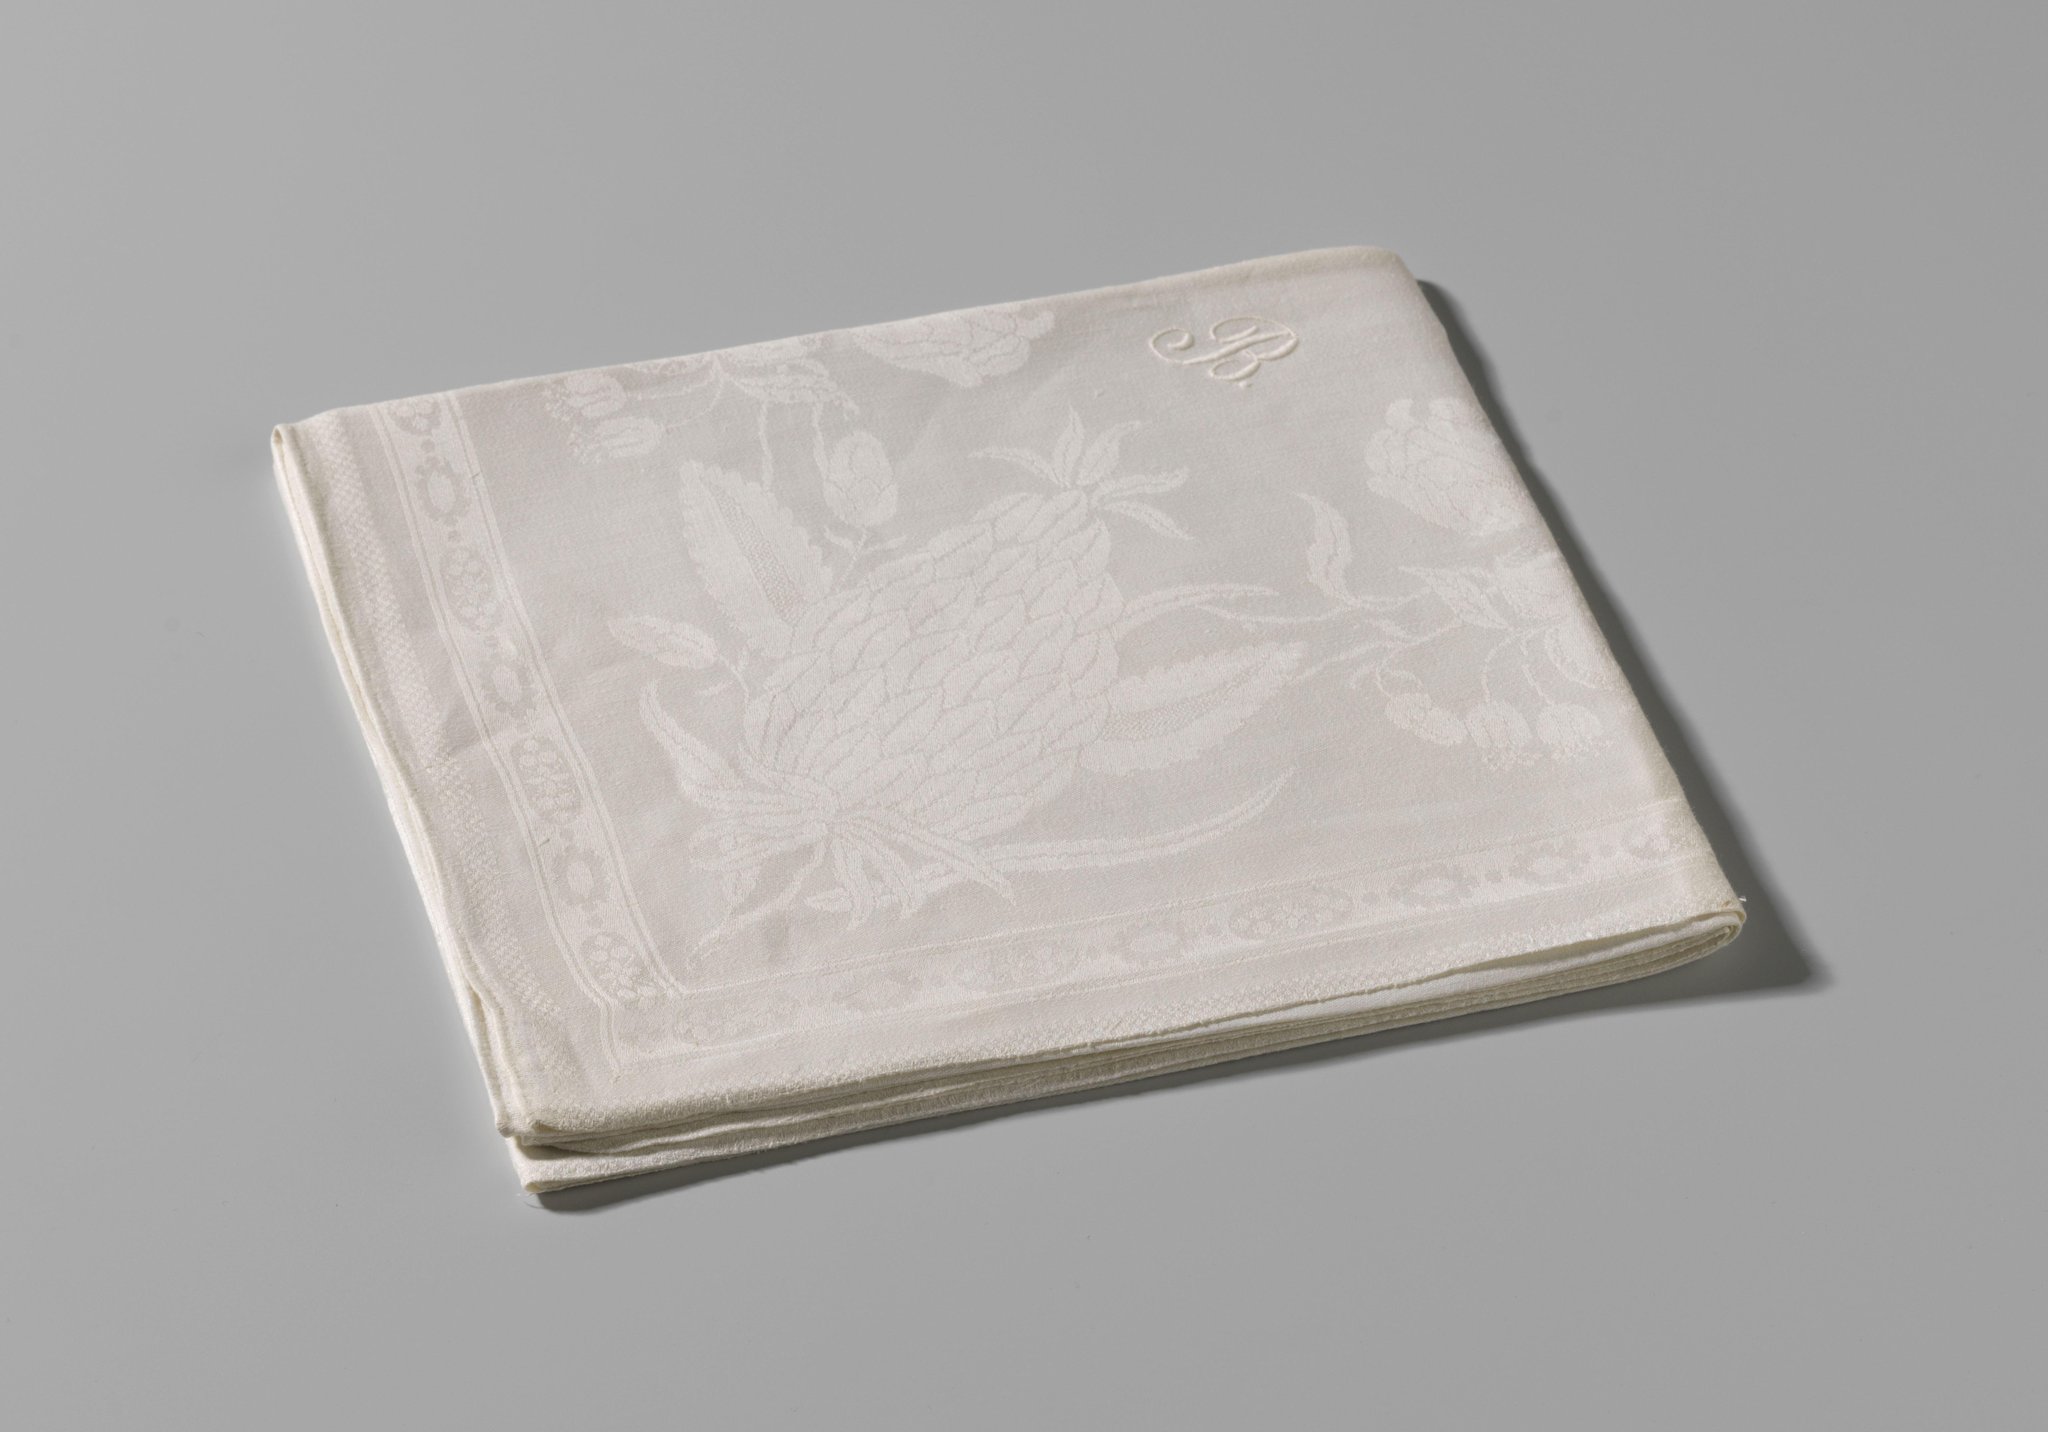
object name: napkin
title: Servet van linnendamast met dessin van ananassen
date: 1875-1924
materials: linen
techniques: damask, embroidered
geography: netherlands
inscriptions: monogram: ‘B’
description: Servet van wit linnendamast met een dessin van ananassen, geborduurde B. Nederland, Kampen, 19de eeuw.